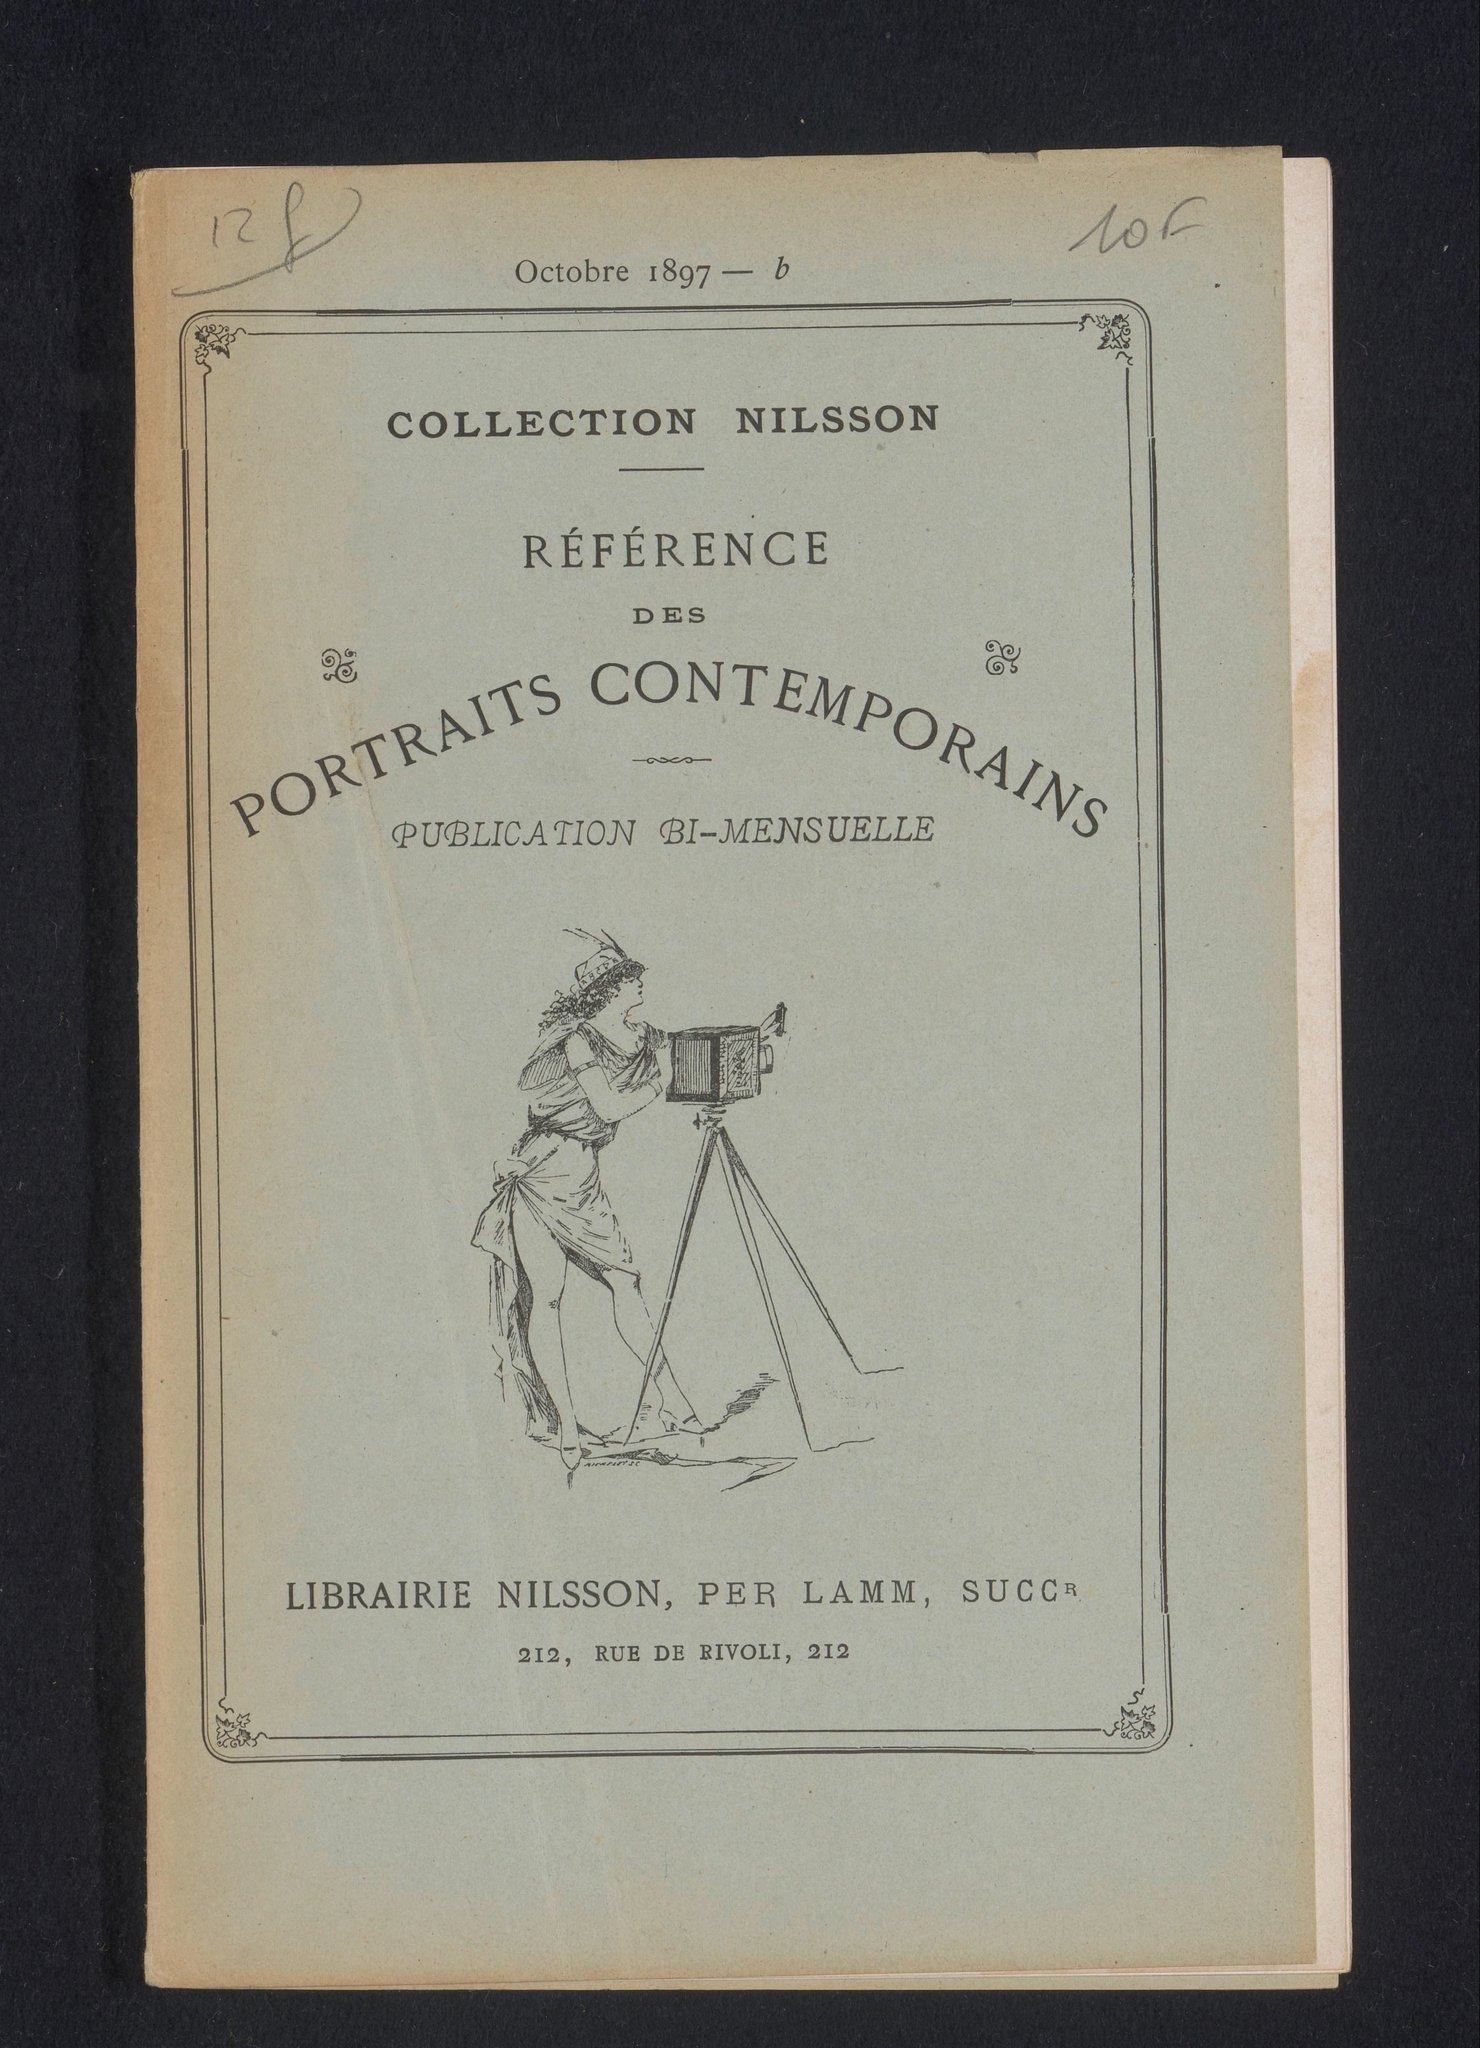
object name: magazine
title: Référence des portraits contemporains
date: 1810-1897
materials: paper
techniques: photograph, printing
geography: paris